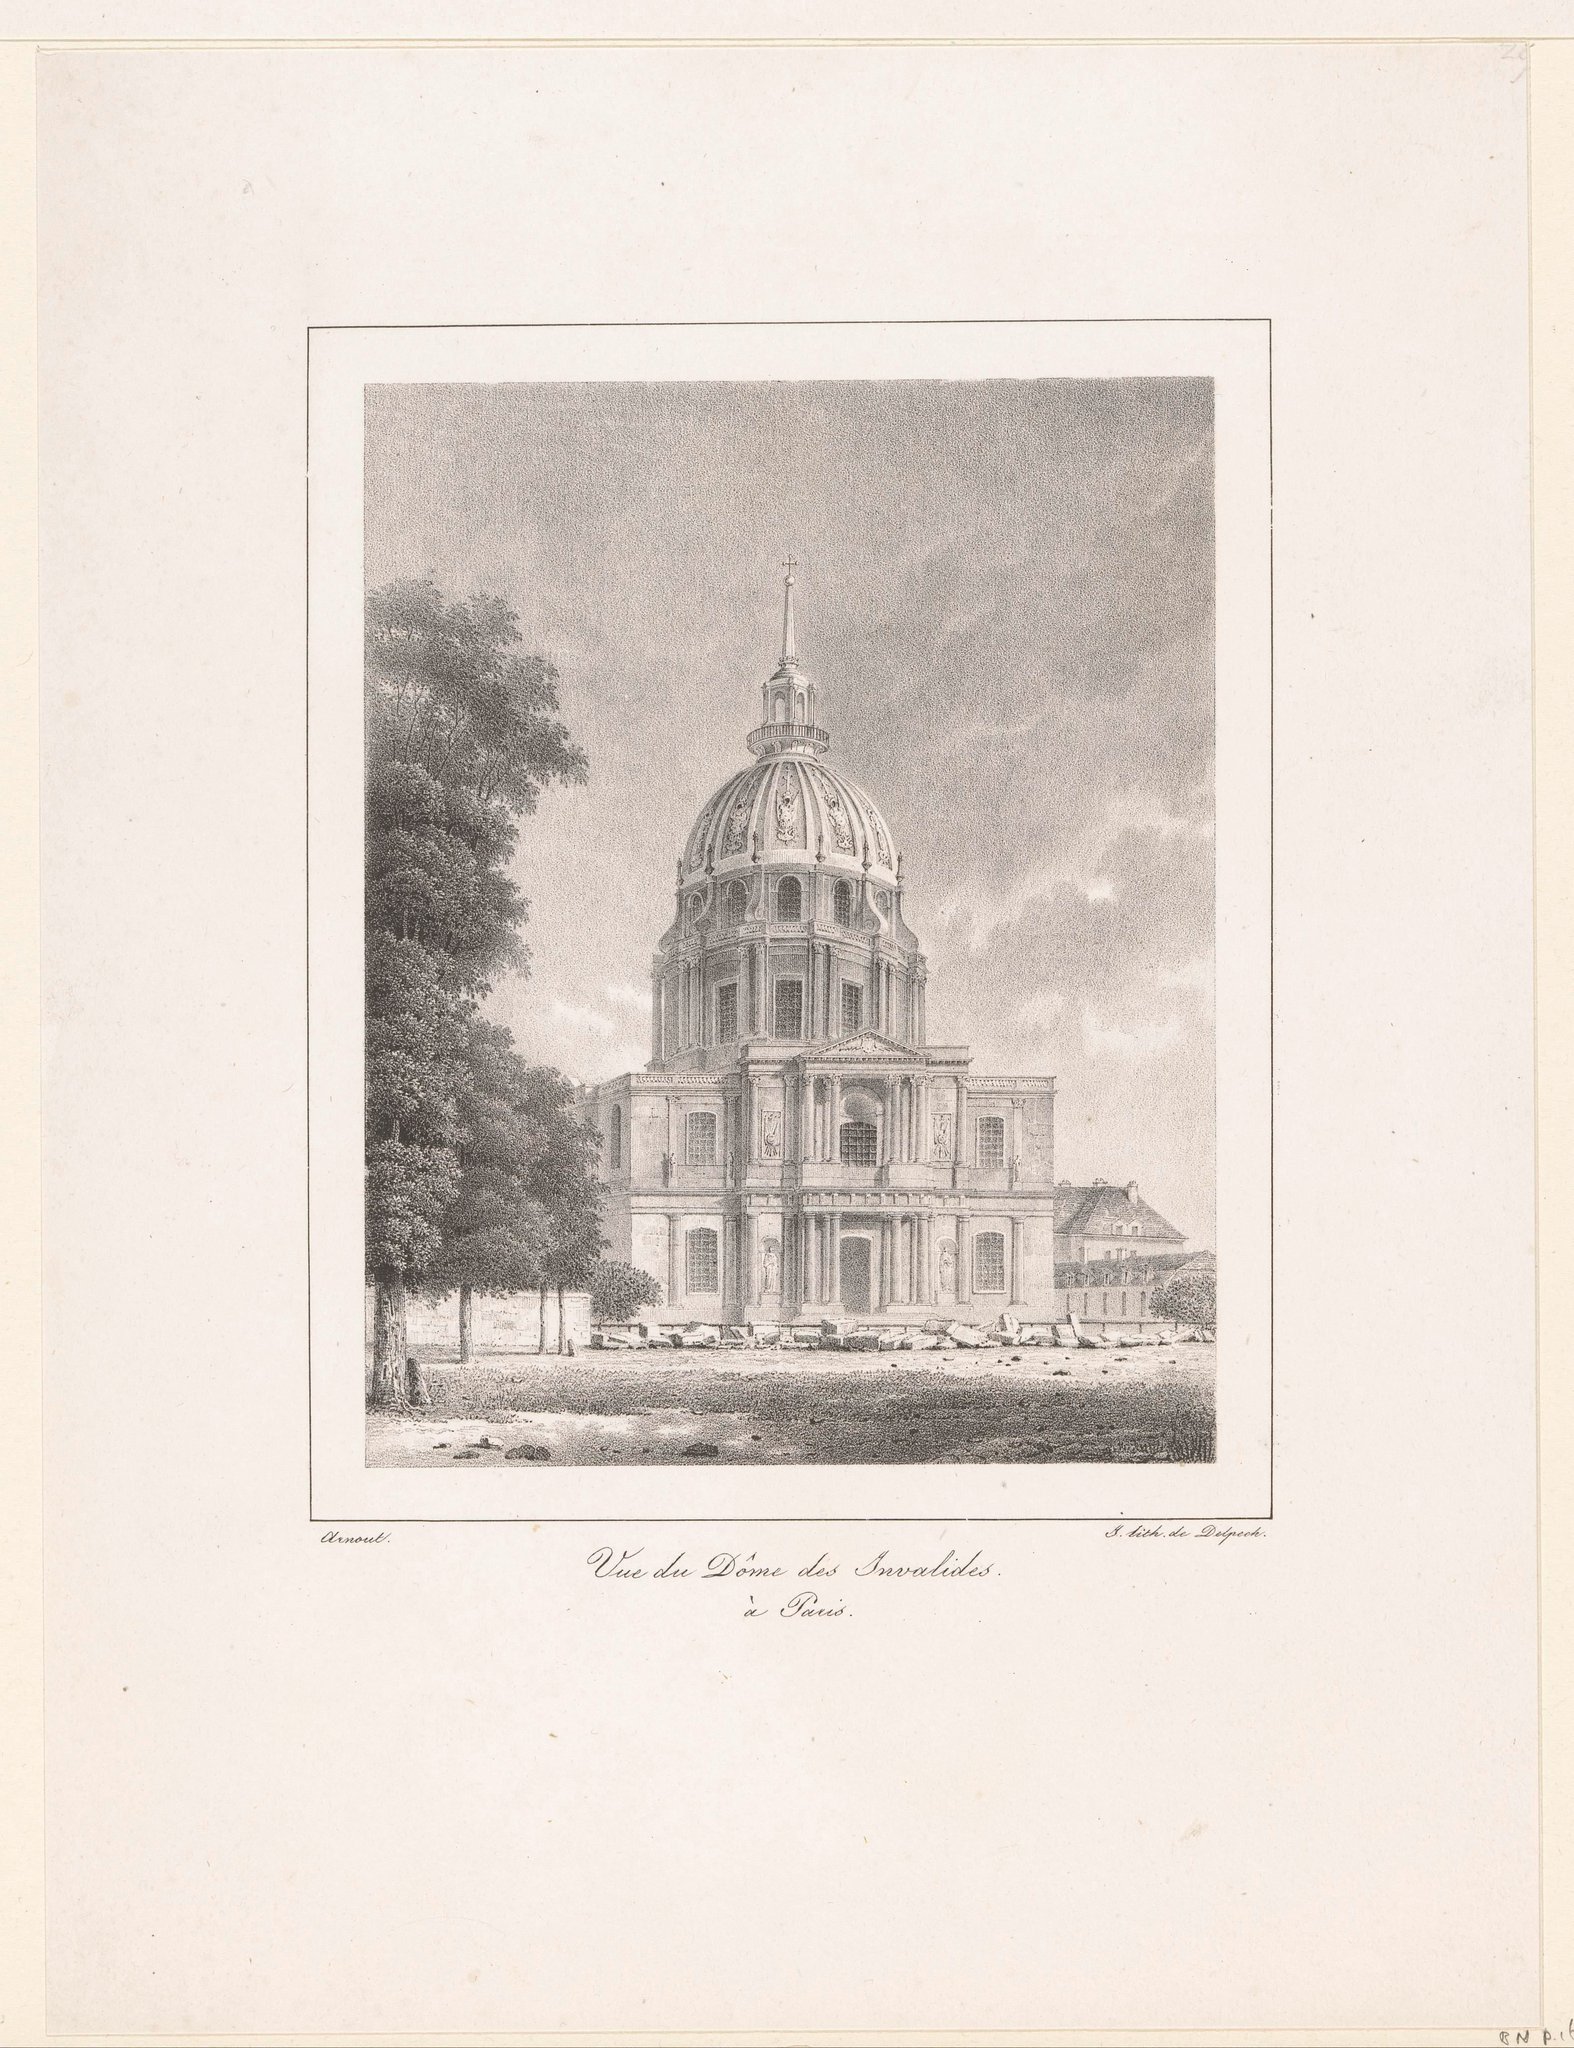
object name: print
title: Kleine gezichten van Parijs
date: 1820-1821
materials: paper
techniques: lithograph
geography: paris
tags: church (exterior), dome ~ architecture, paris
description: De serie waar deze prent deel van uit maakt, bestaat waarschijnlijk uit dertig prenten.